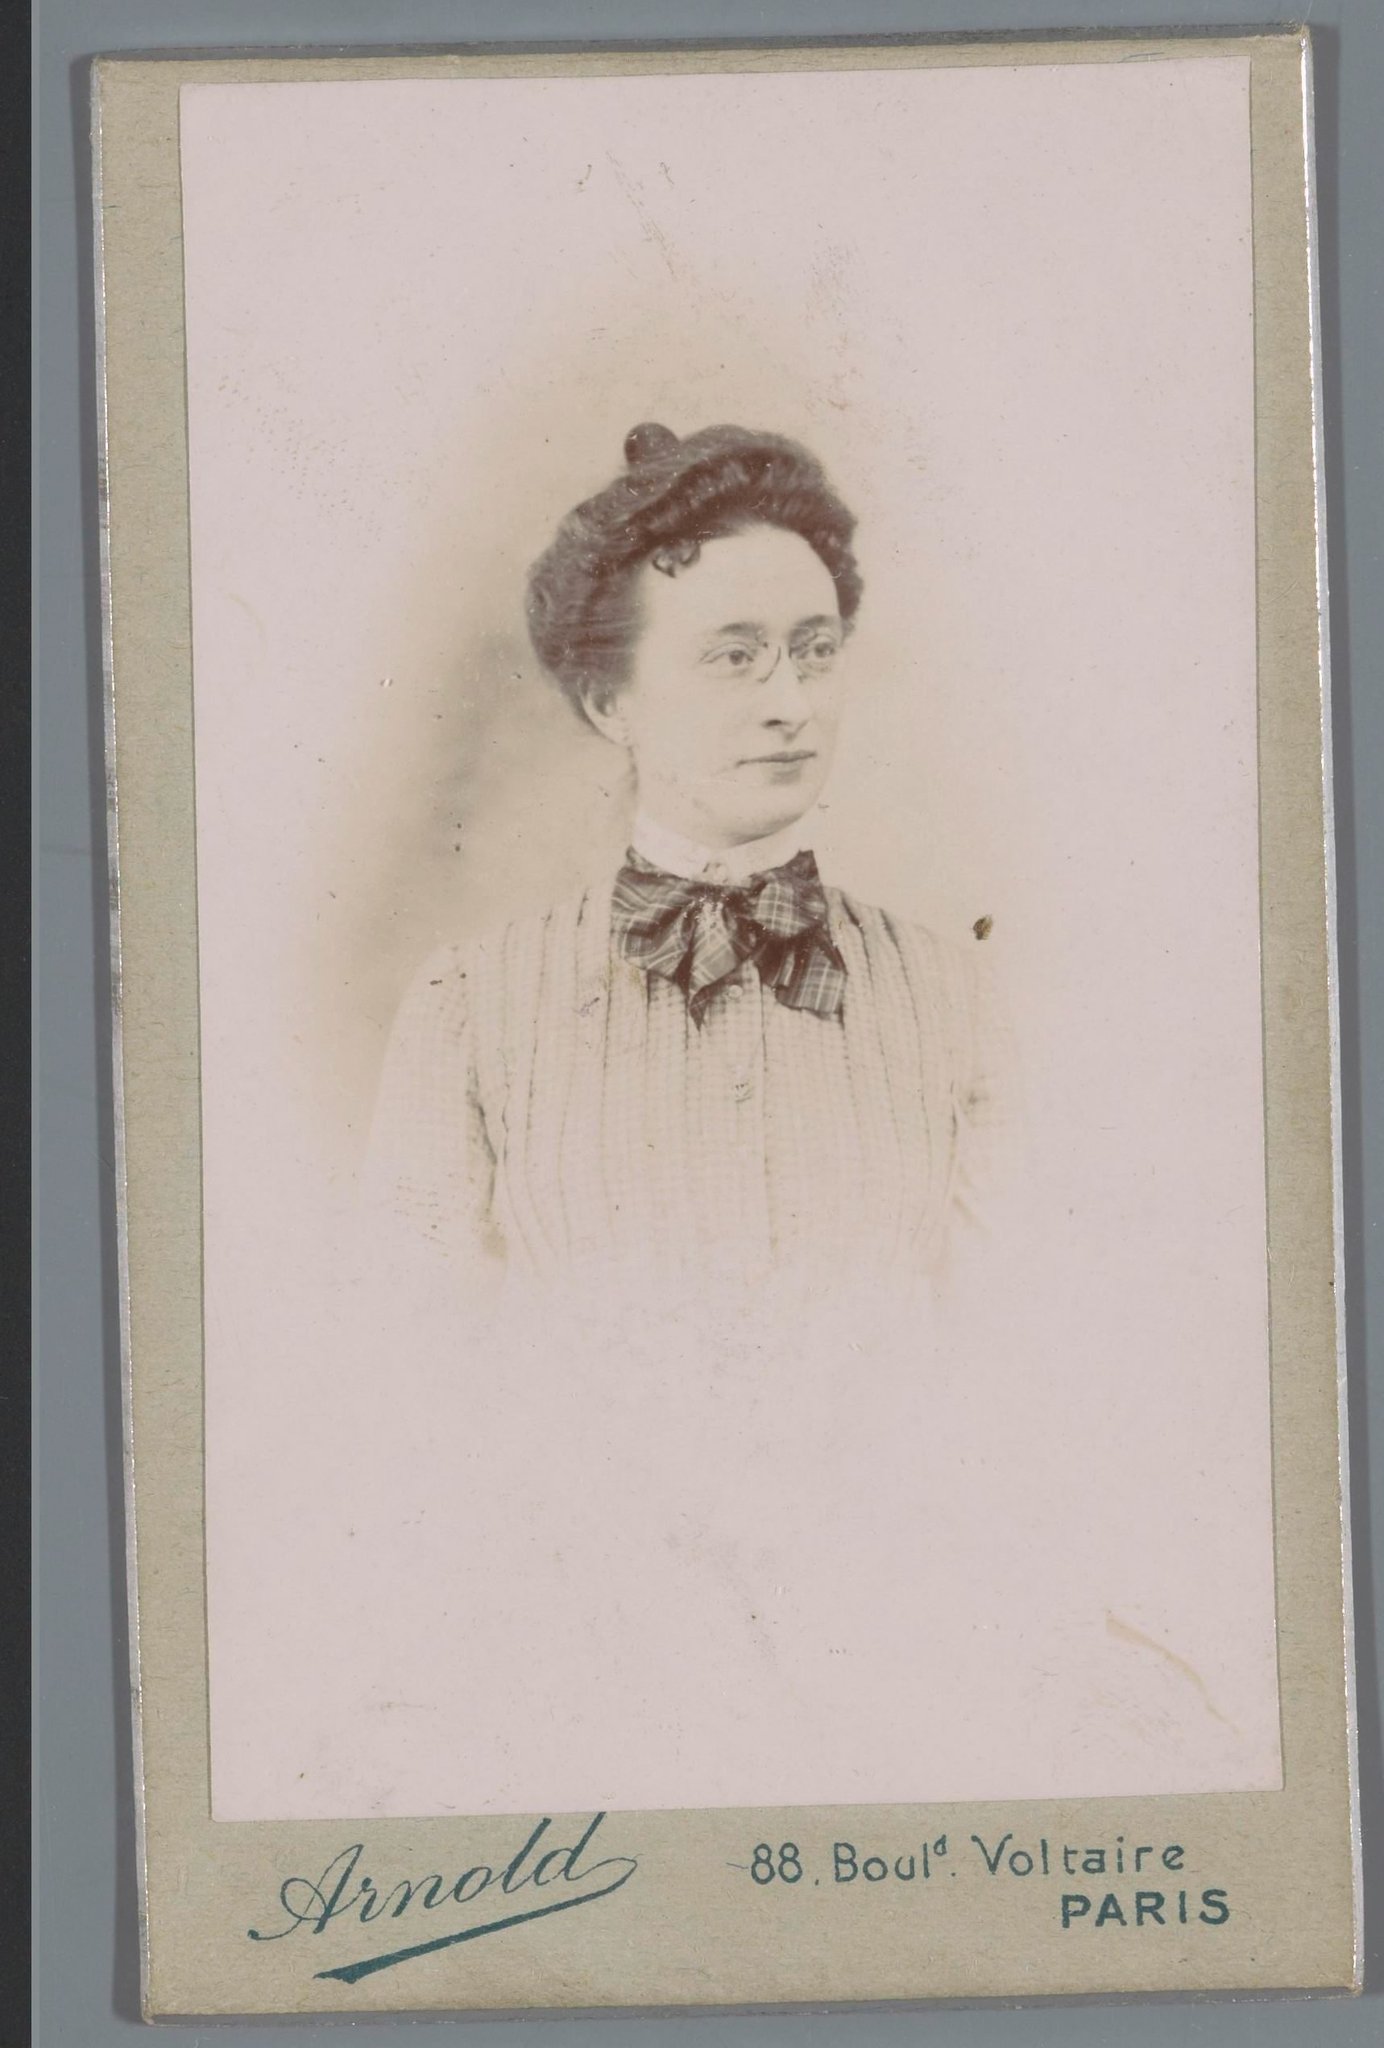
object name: carte de visite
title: Portret van een onbekende jonge vrouw met bril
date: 1890-1910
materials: paper, cardboard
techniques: gelatin silver print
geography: paris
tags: eyeglasses, spectacles, adolescent, young woman, maiden, anonymous historical person portrayed, paris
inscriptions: inscription: ‘Arnold/ 88, Bould. Voltaire/ Paris’, inscription: ‘Mon. Arnold/ Grande Photographie/ St. Ambroise/ 88/ Boulevard Voltaire/ (Entrée: impasse Truillot)/ au 1er. Etage/ Paris/ Les Clichés sont conservés’